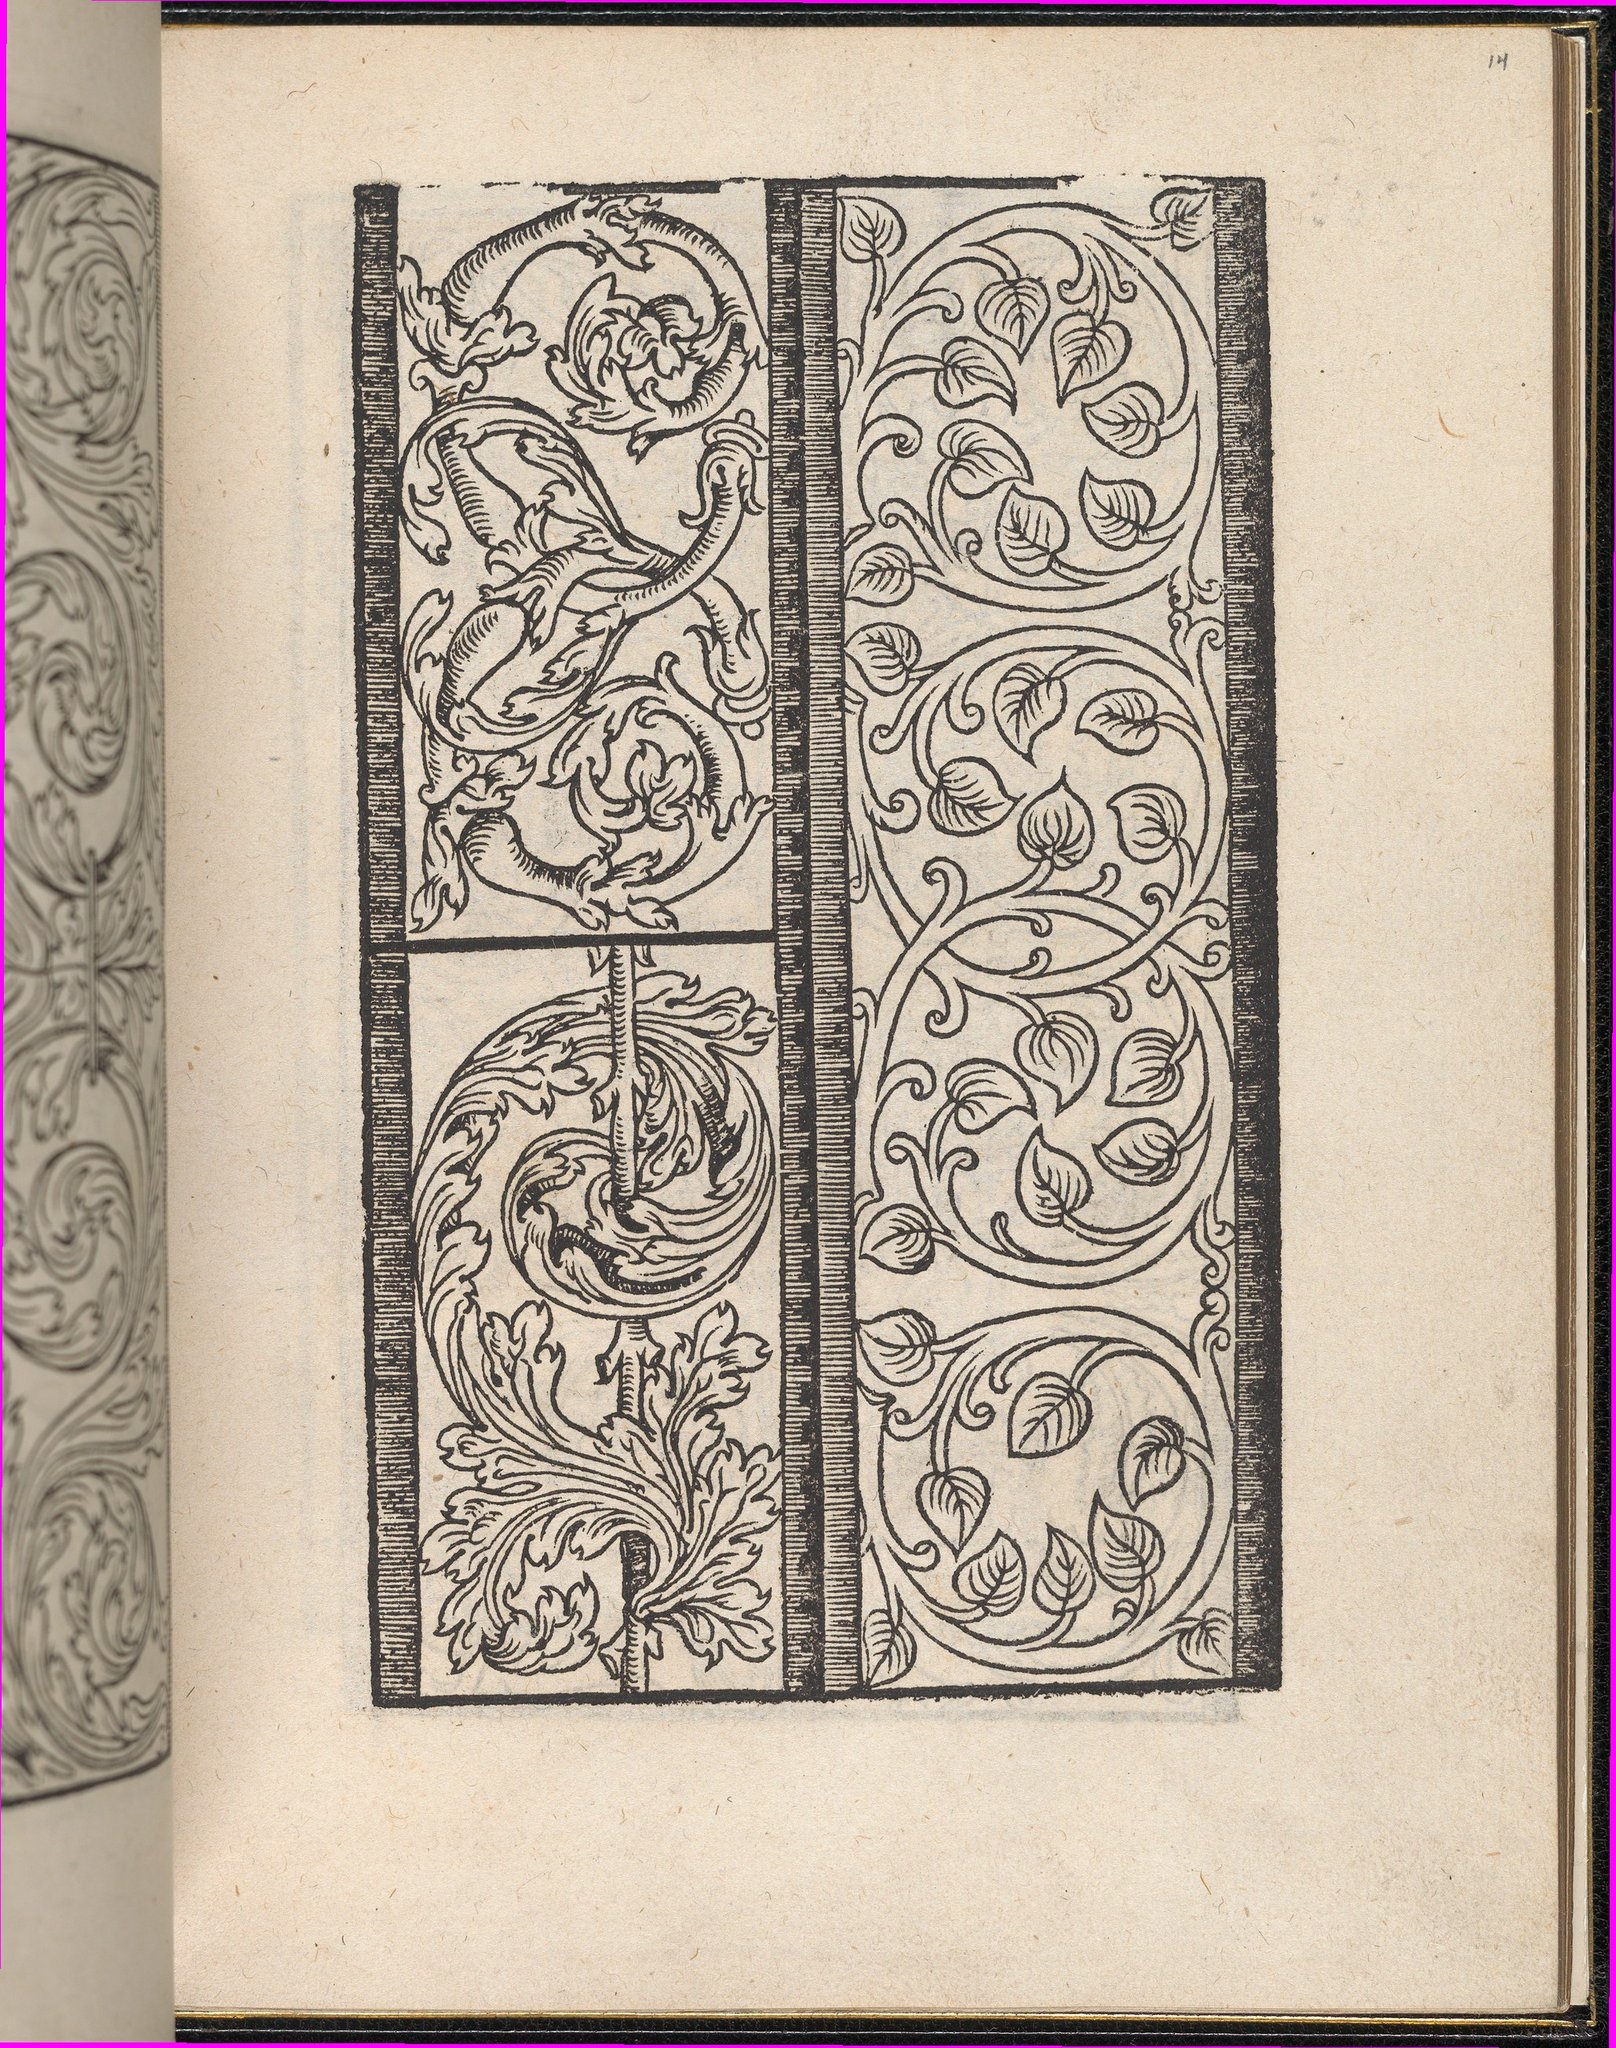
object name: book print ornament architecture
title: Page from Ein new kunstlich Modelbuch...(Page 14r)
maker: peter quentel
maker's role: publisher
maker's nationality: german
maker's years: 1500-1550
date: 1544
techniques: woodcut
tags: ornament